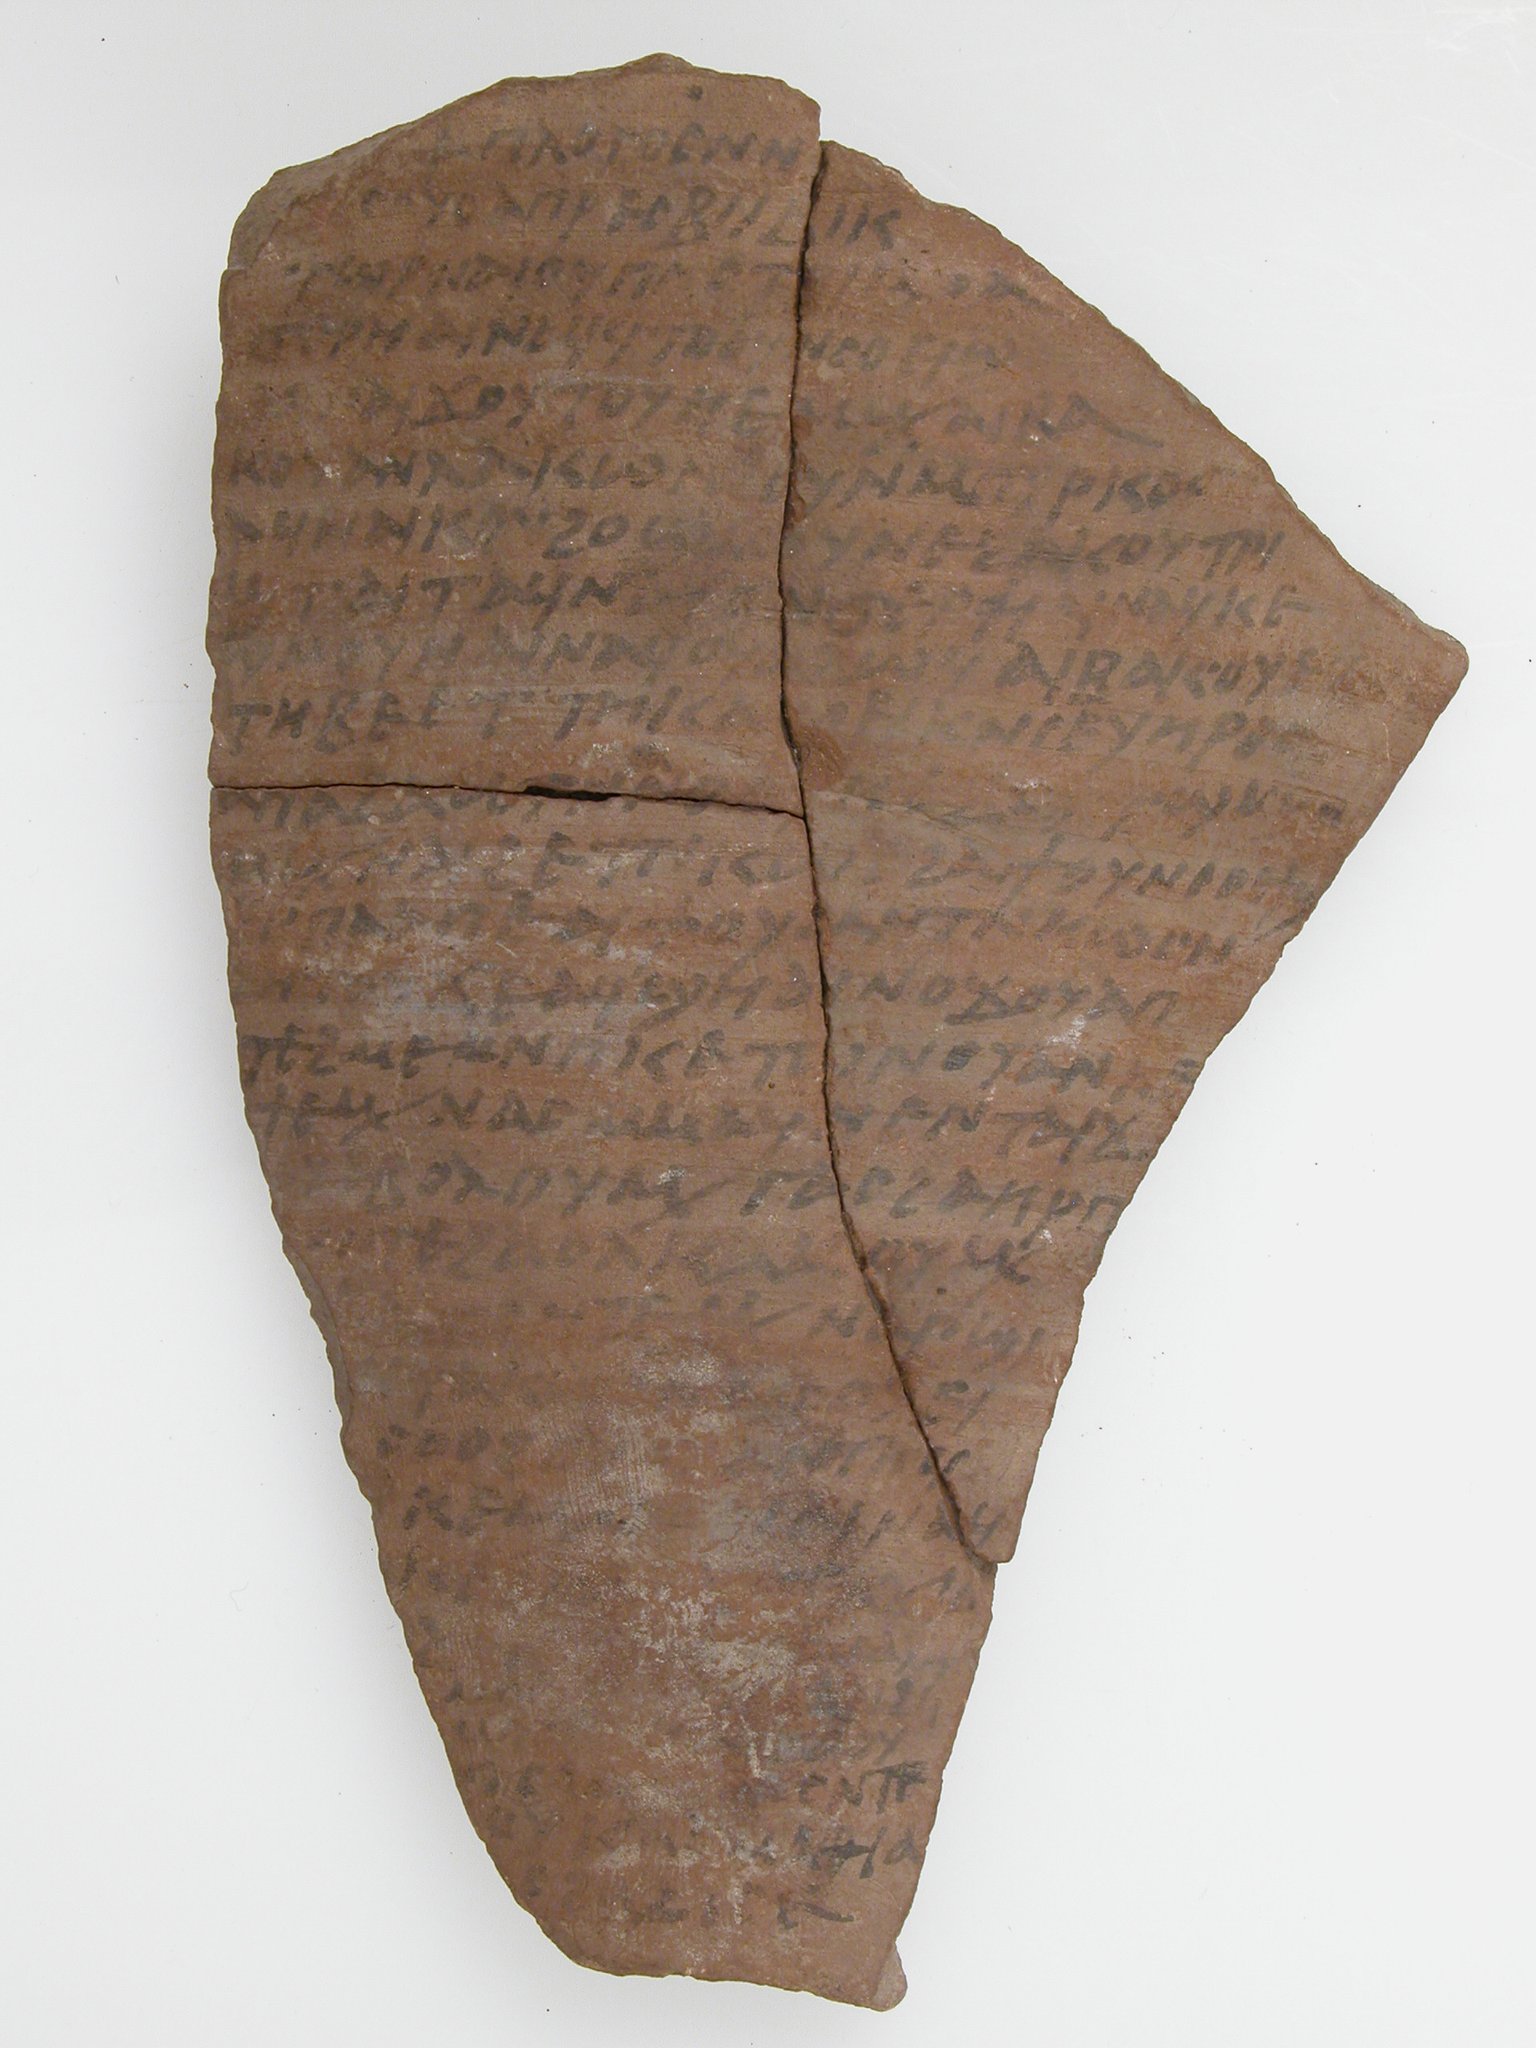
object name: ostrakon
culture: coptic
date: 601-700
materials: ink, pottery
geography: egypt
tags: documents